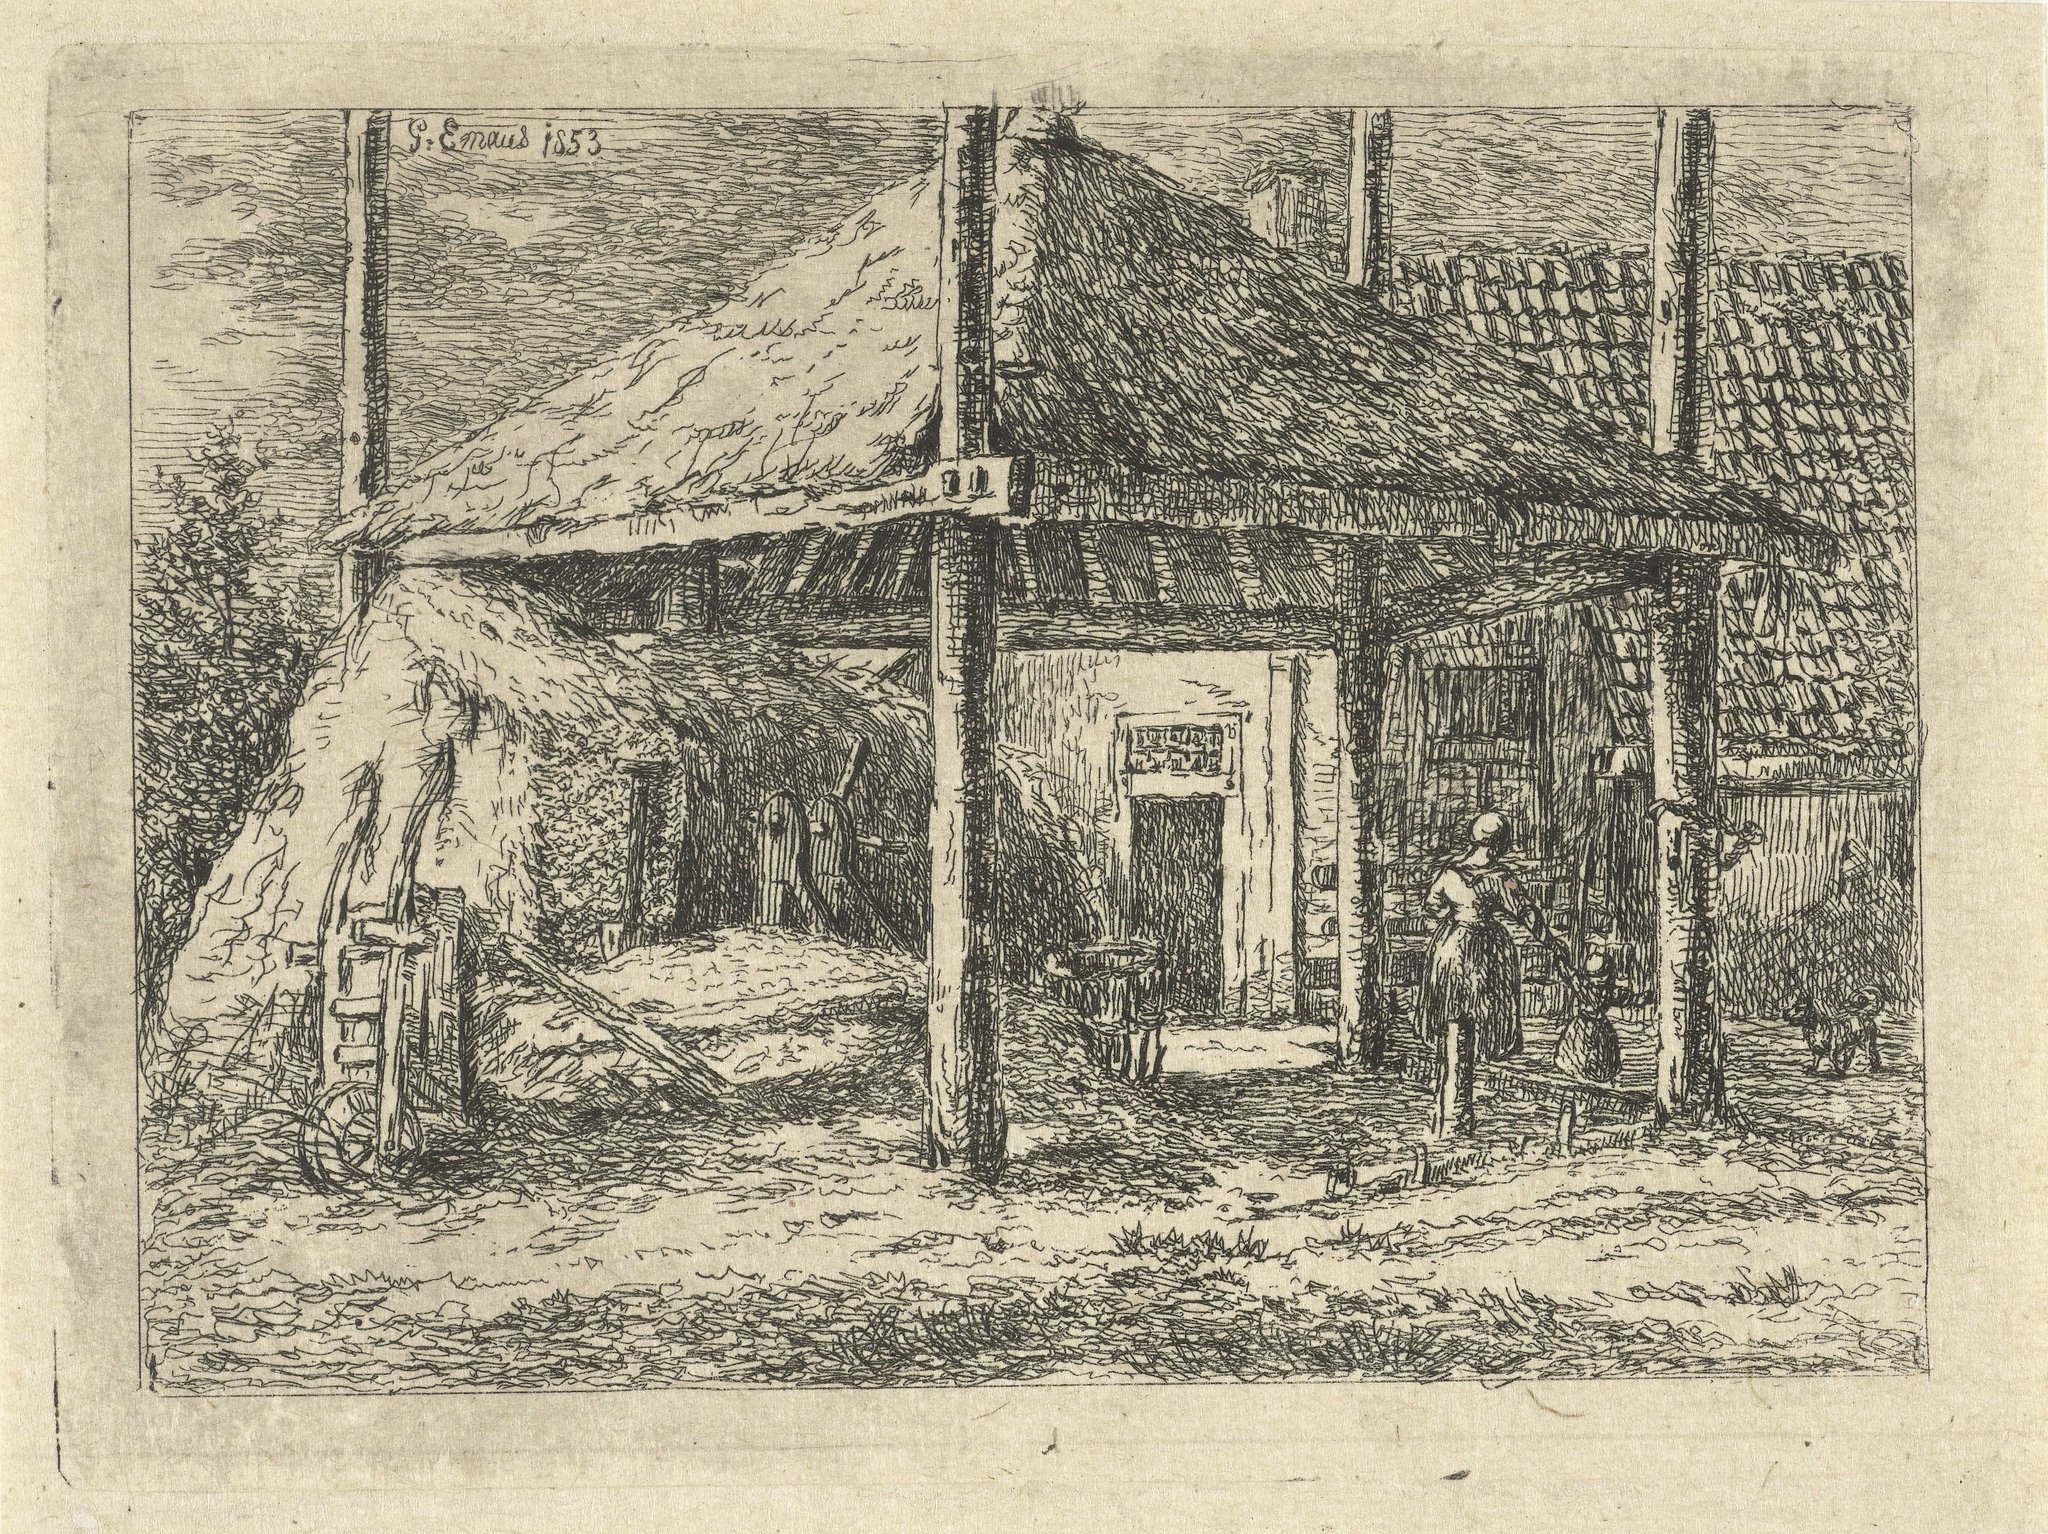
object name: print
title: Dak van een hooischelf te Pernis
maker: gerardus emaus de micault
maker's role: draughtsman, print maker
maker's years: 1798-1863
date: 1853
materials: paper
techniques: etching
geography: netherlands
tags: hay-stack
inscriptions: collector's mark: Lugt 2228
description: Tussen een hooiberg en een boerderij staan een moeder en kind bij een hond.